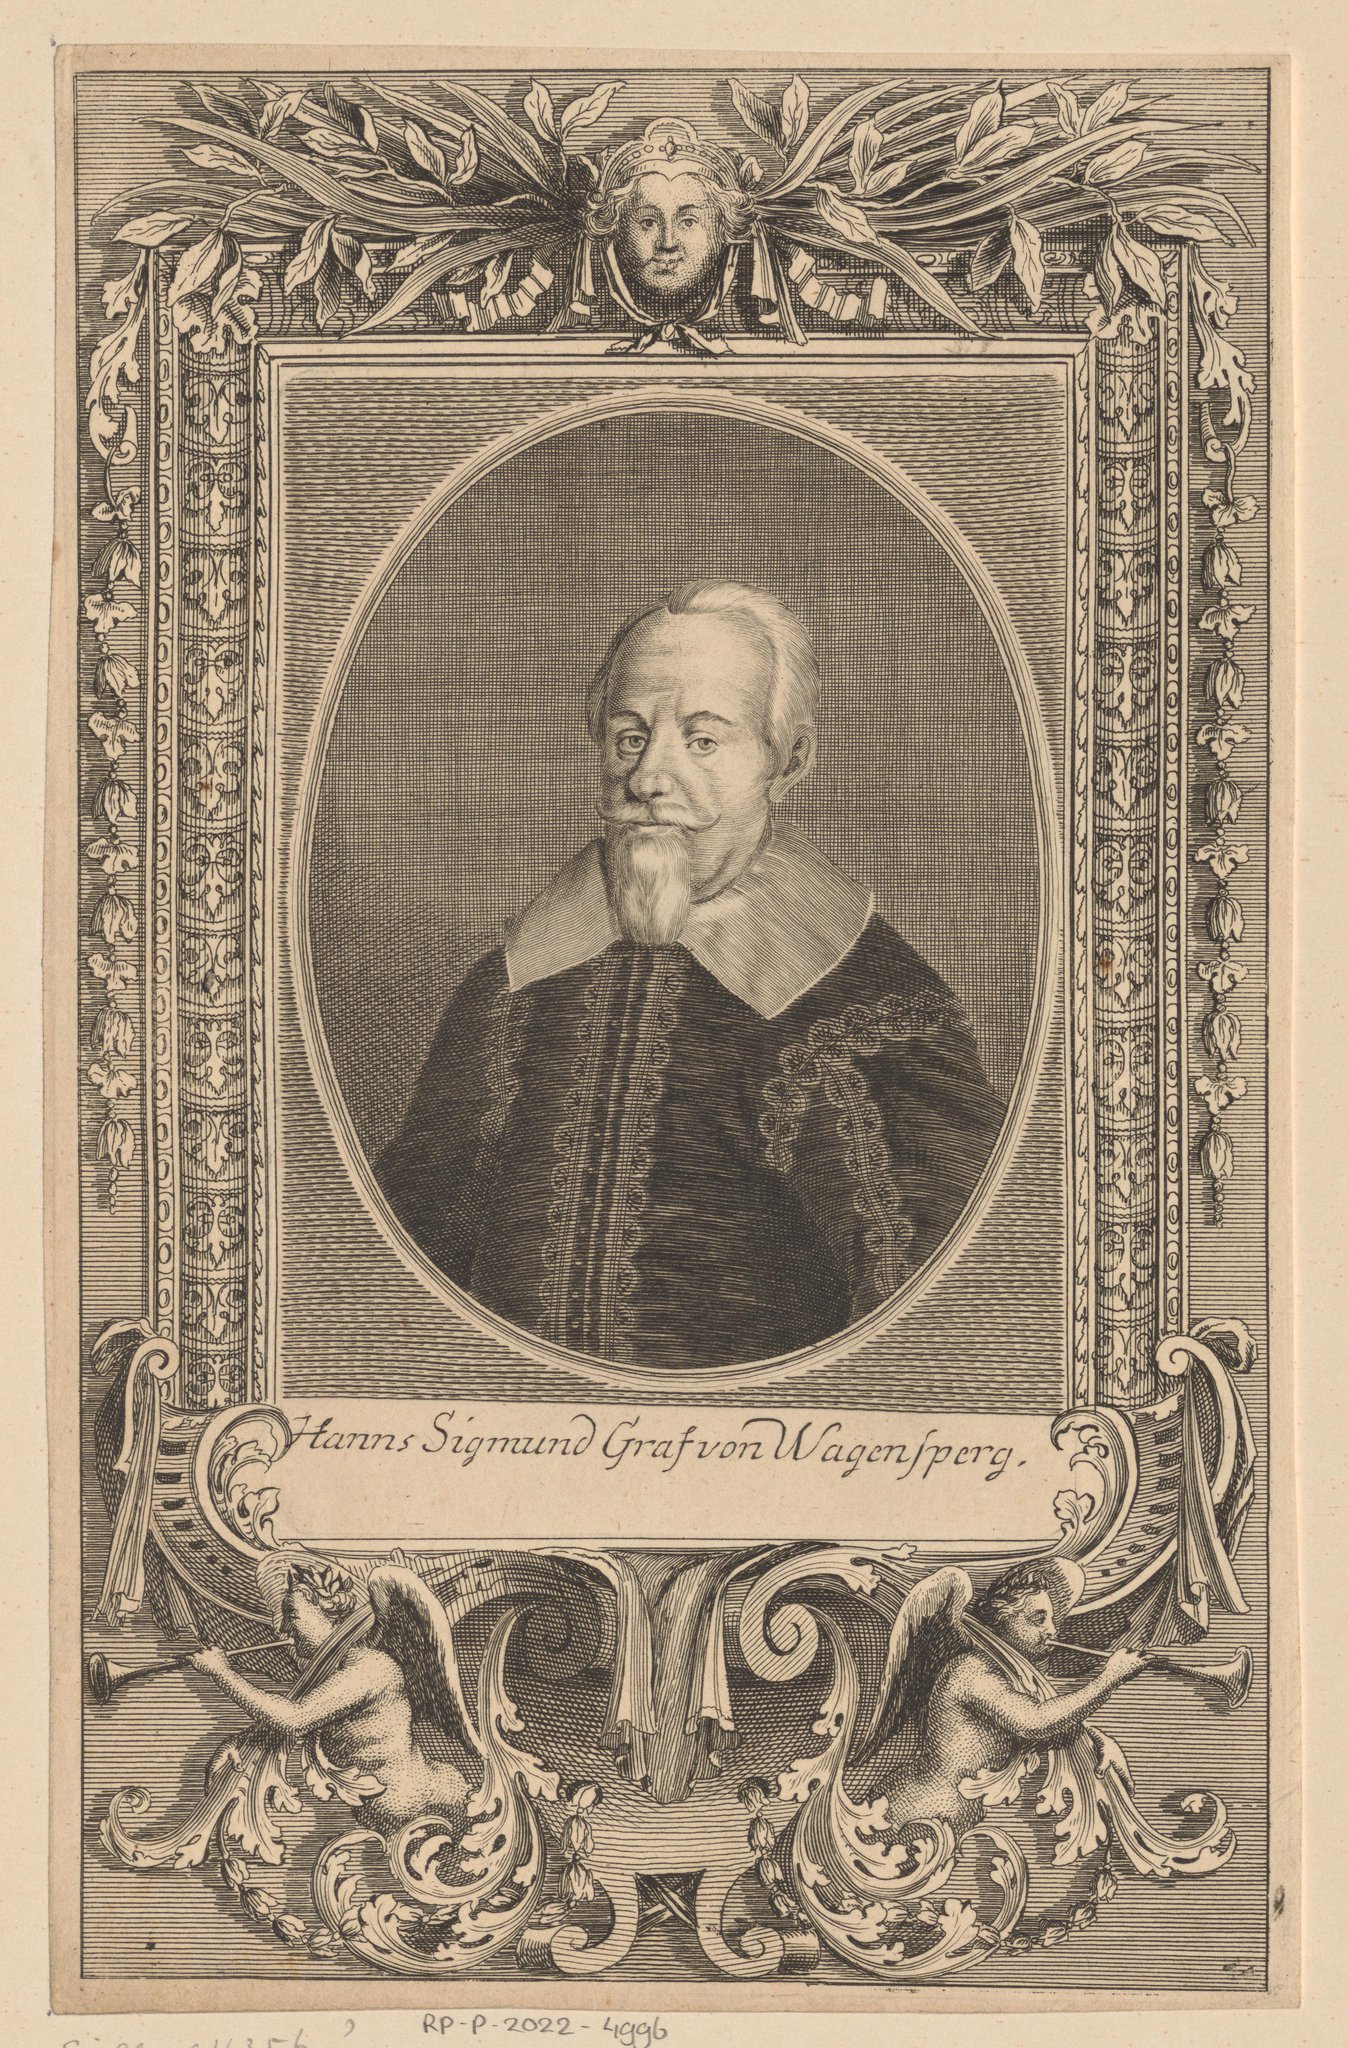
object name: print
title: Portret van Johann Siegmund von Wagensperg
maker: Anonymous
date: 1722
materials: paper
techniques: engraving, etching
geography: germany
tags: historical persons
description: Prent met andere omlijsting gebruikt in: Khevenhüller, Franz Christoph. Conterfet Kupfferstich (...). Leipzig: Moritz Georg Weidmann, 1722, dl. 2.